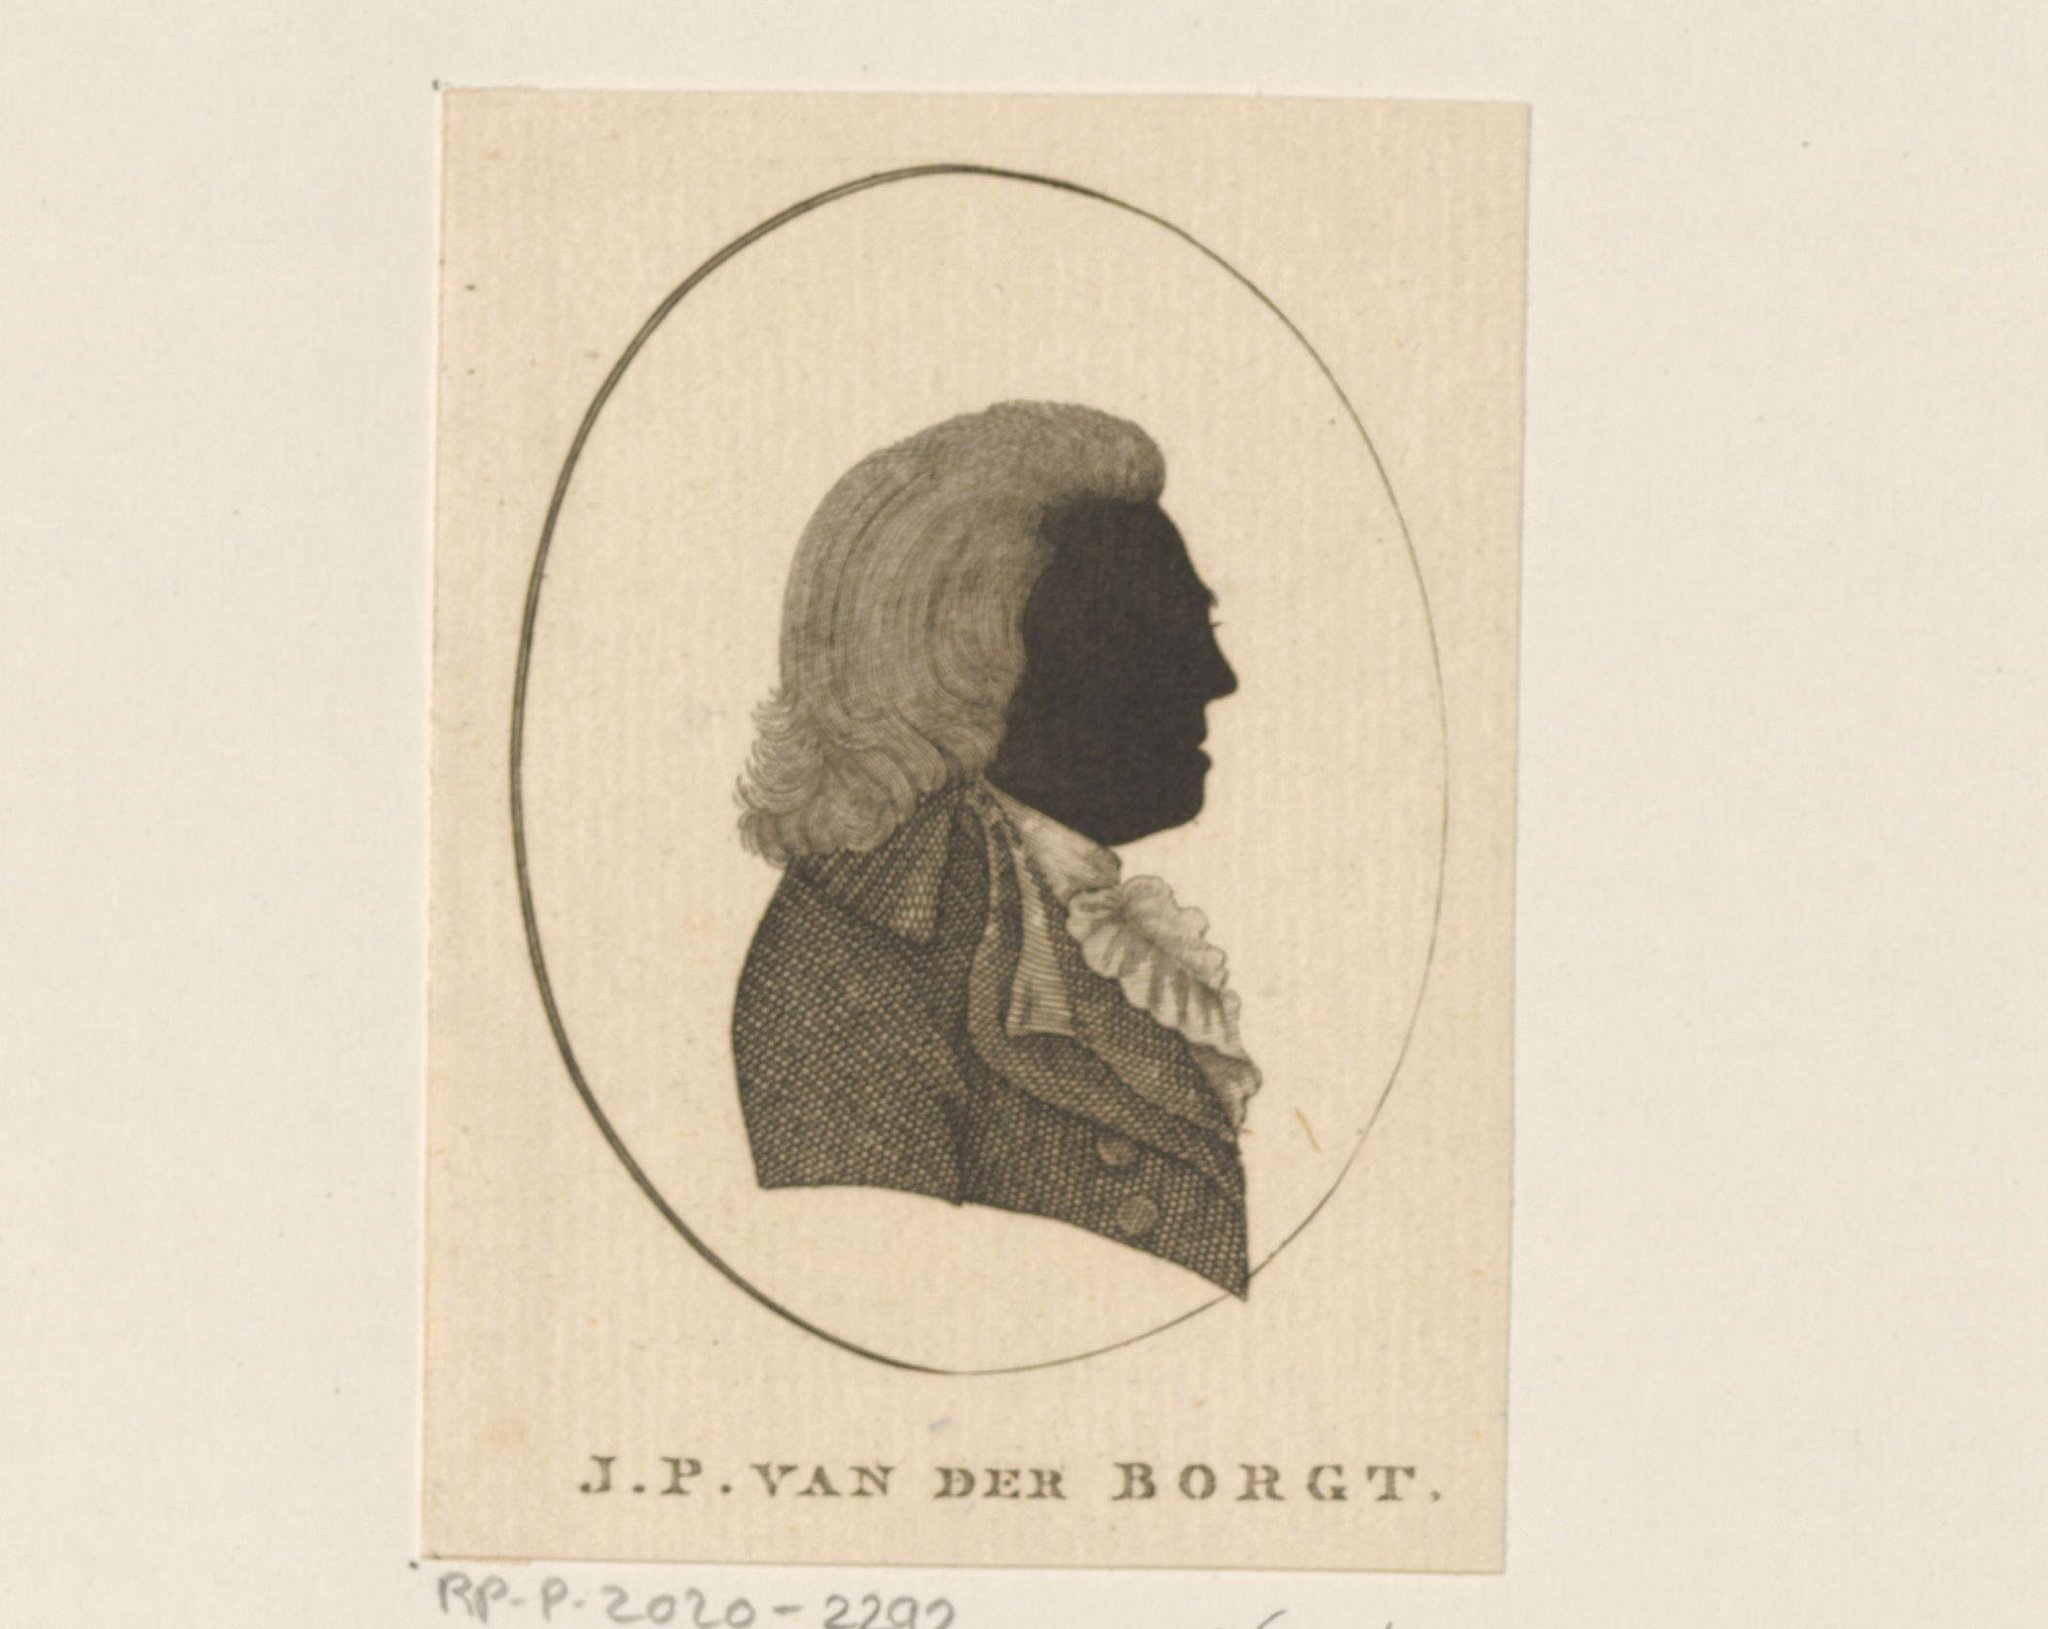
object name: book illustration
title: Silhouetportret van Johannes Petrus van der Borght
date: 1799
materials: paper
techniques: etching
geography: amsterdam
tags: politician, historical persons, politician, e.g. party leader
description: Prent uit: Rogge, Cornelis. Geschiedenis der staatsregeling, voor het Bataafsche volk. Amsterdam: Johannes Allart, 1799.